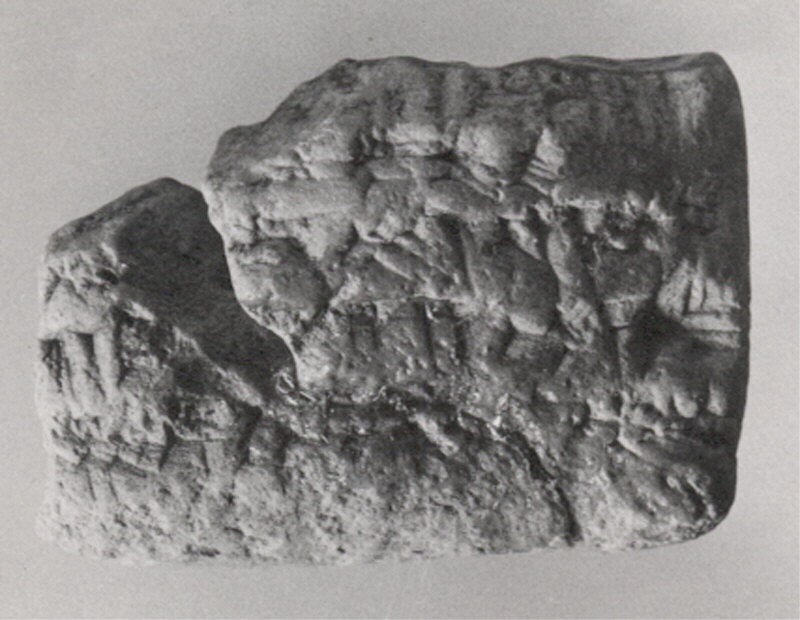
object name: cuneiform tablet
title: Cuneiform tablet: promissory note for dates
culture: babylonian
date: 626-539 BCE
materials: clay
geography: mesopotamia